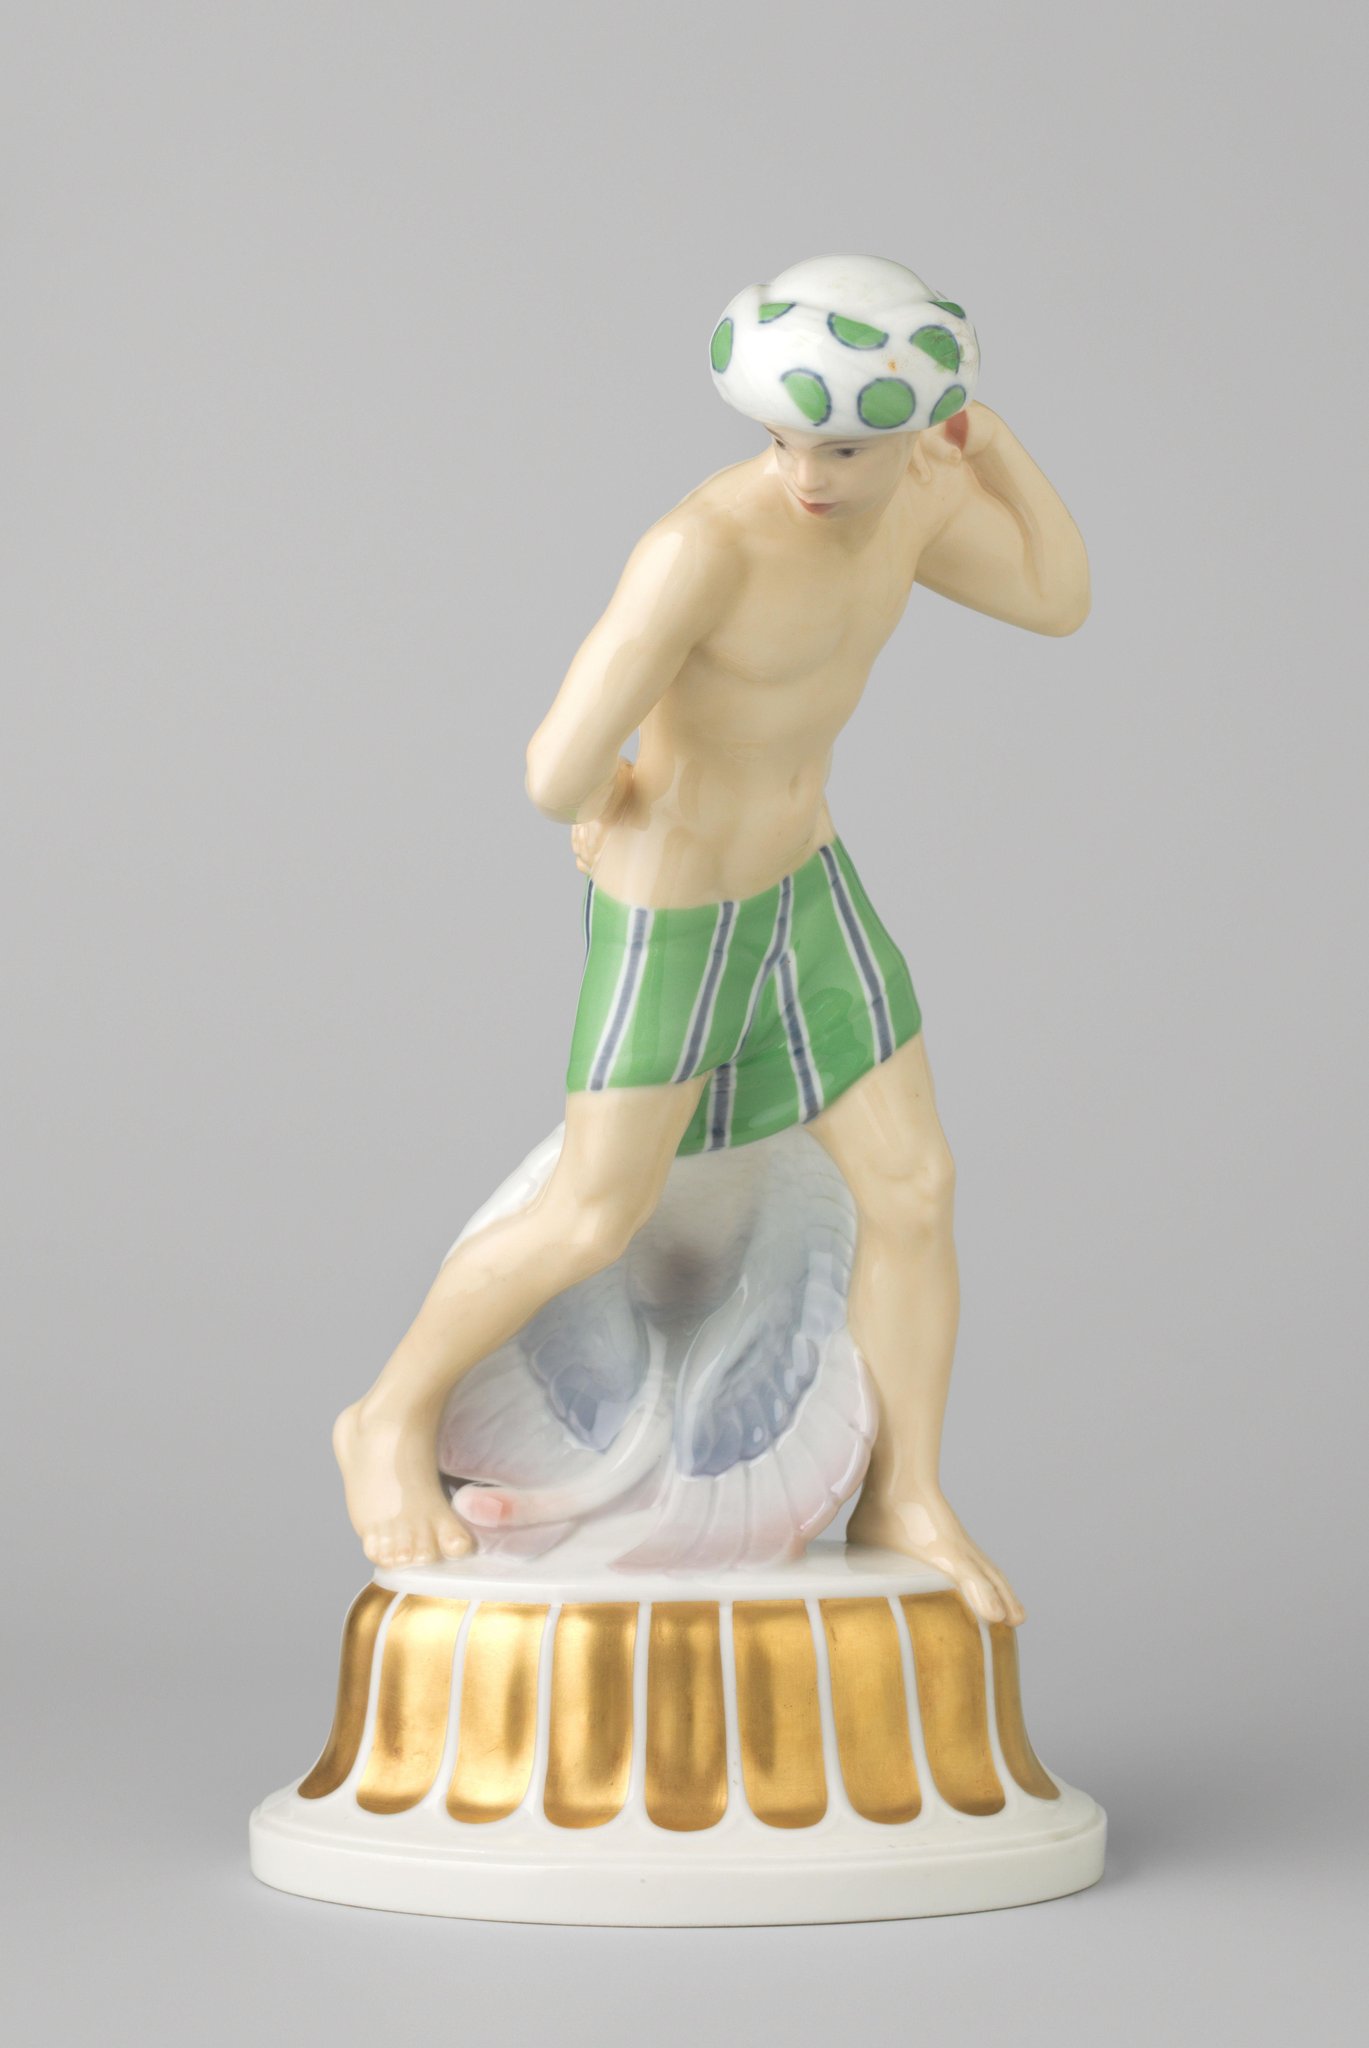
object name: figure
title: Figure in the shape of a man with a turkey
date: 1903-1915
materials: glaze, gold, paint, porcelain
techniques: firing, forming, gilding, vitrification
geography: berlin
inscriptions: signature: ‘Amberg’, mark: ‘scepter/ 140/849/ rijksappel met K.P.M in blauw/ driehoek en P. (maart 1915)/ B./ M15 HH[?] 96168’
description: Indian with turkey. Porcelain. Berlin, Königliche Porzellan Manufaktur, 1915, designed by Adolf Amberg 1905.